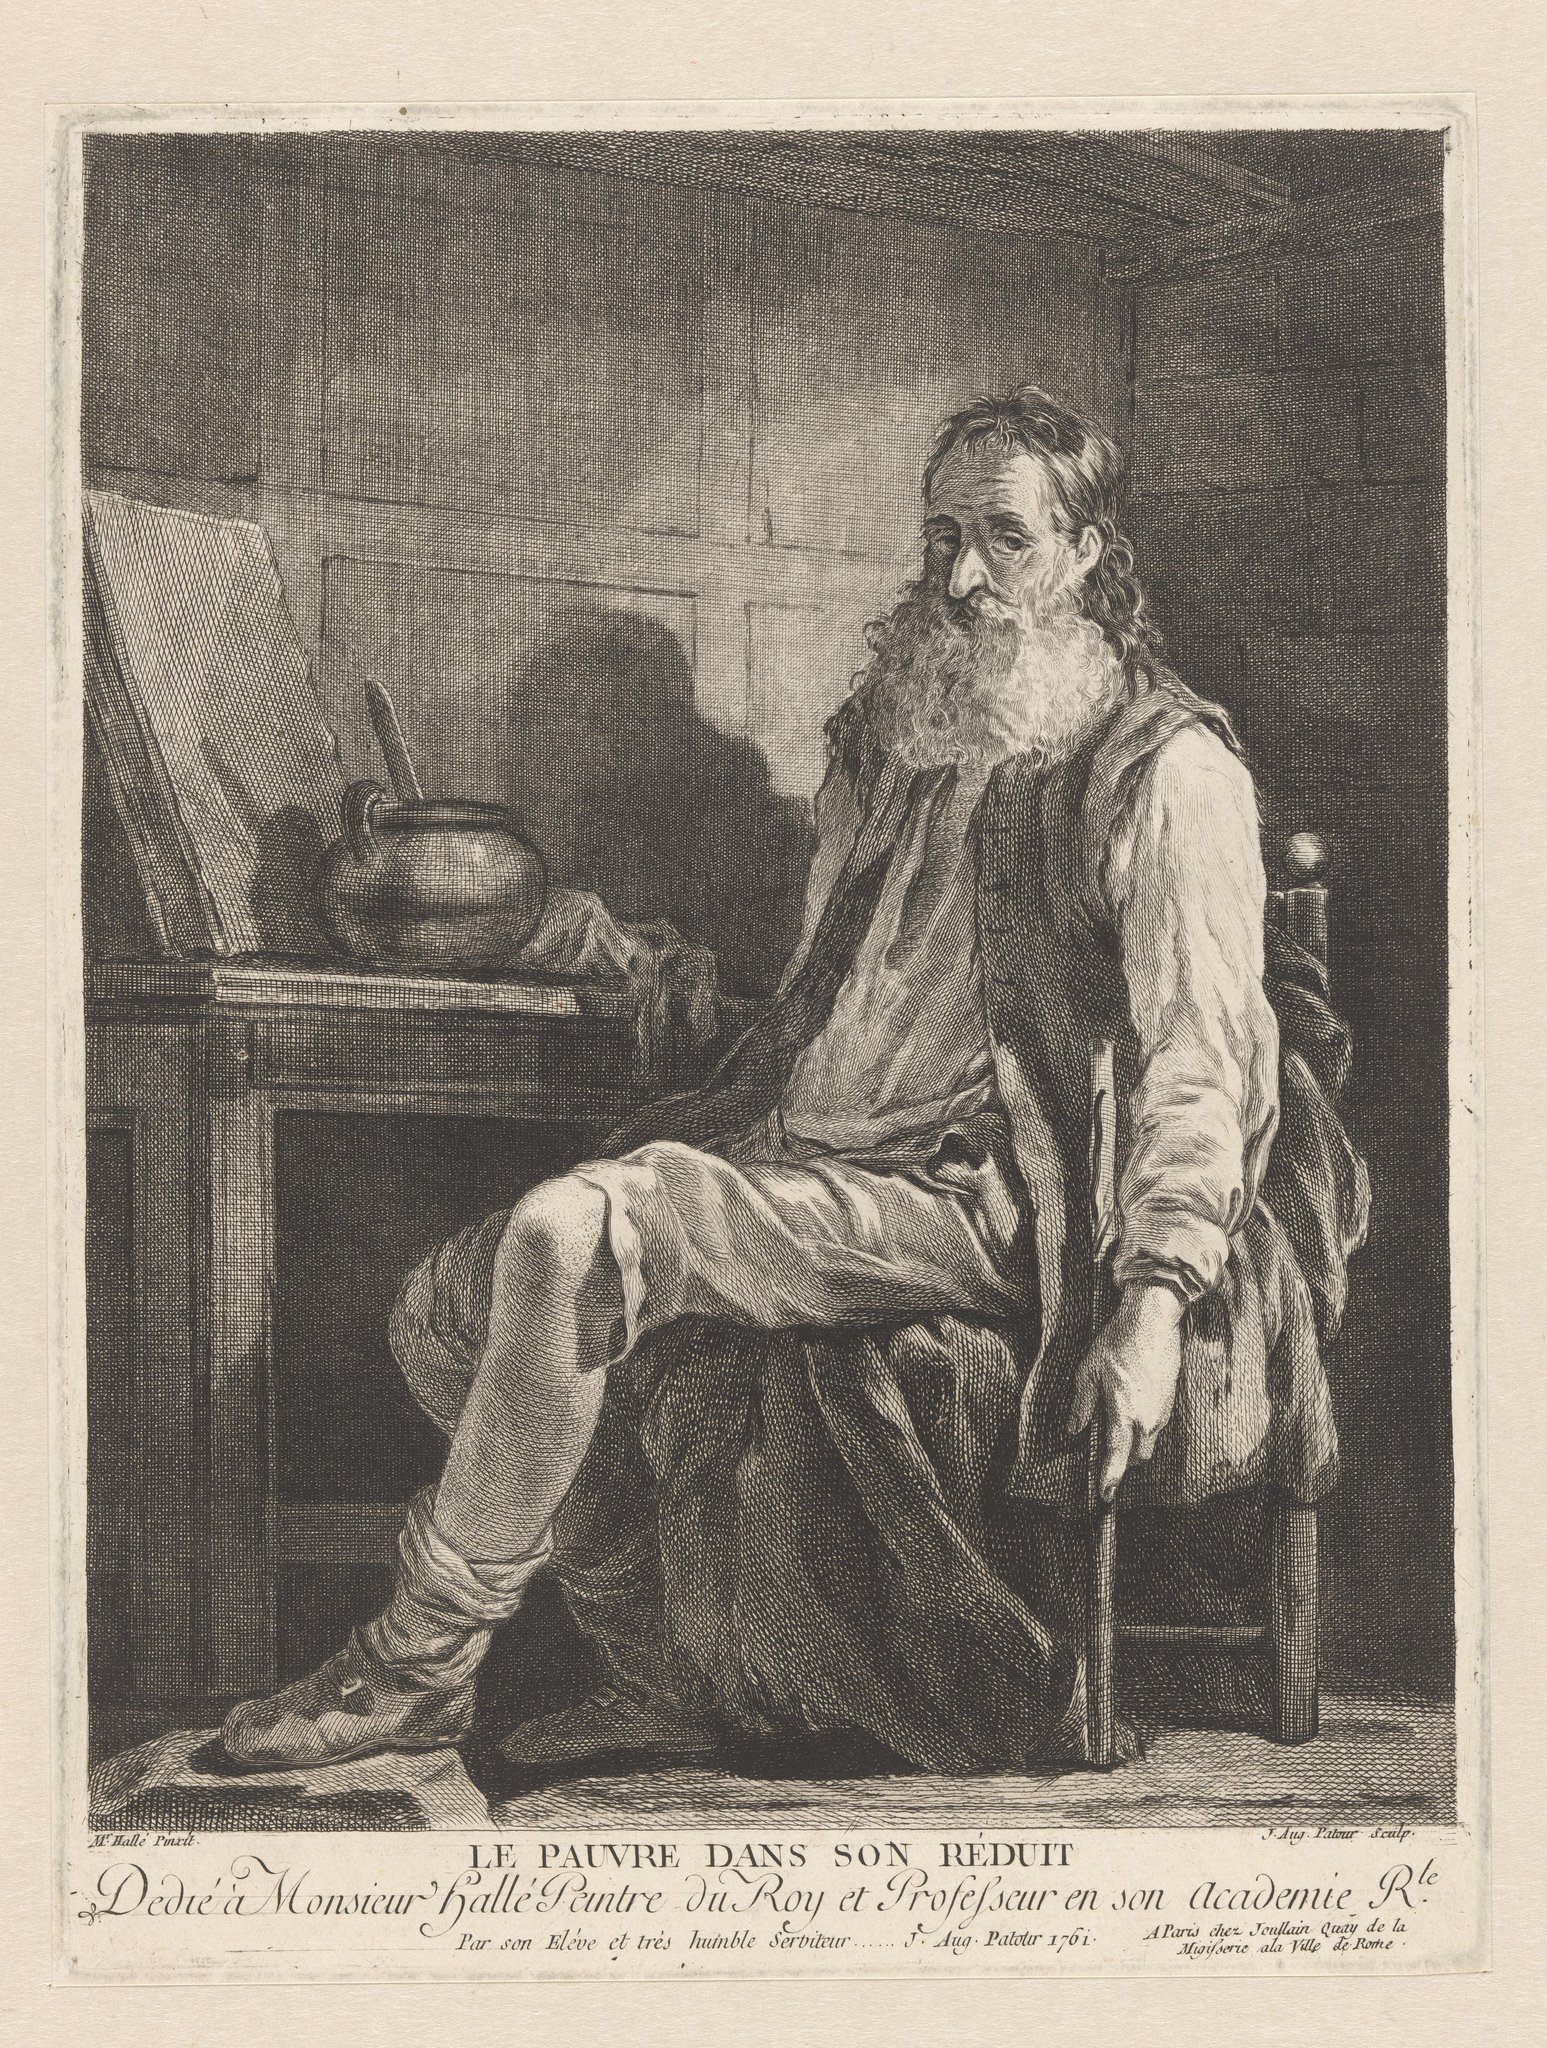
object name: print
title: Le pauvre dans son réduit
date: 1761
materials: ink, paper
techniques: engraving, etching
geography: paris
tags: the poor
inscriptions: collector's mark: Lugt 2228, collector's mark: Lugt 2760